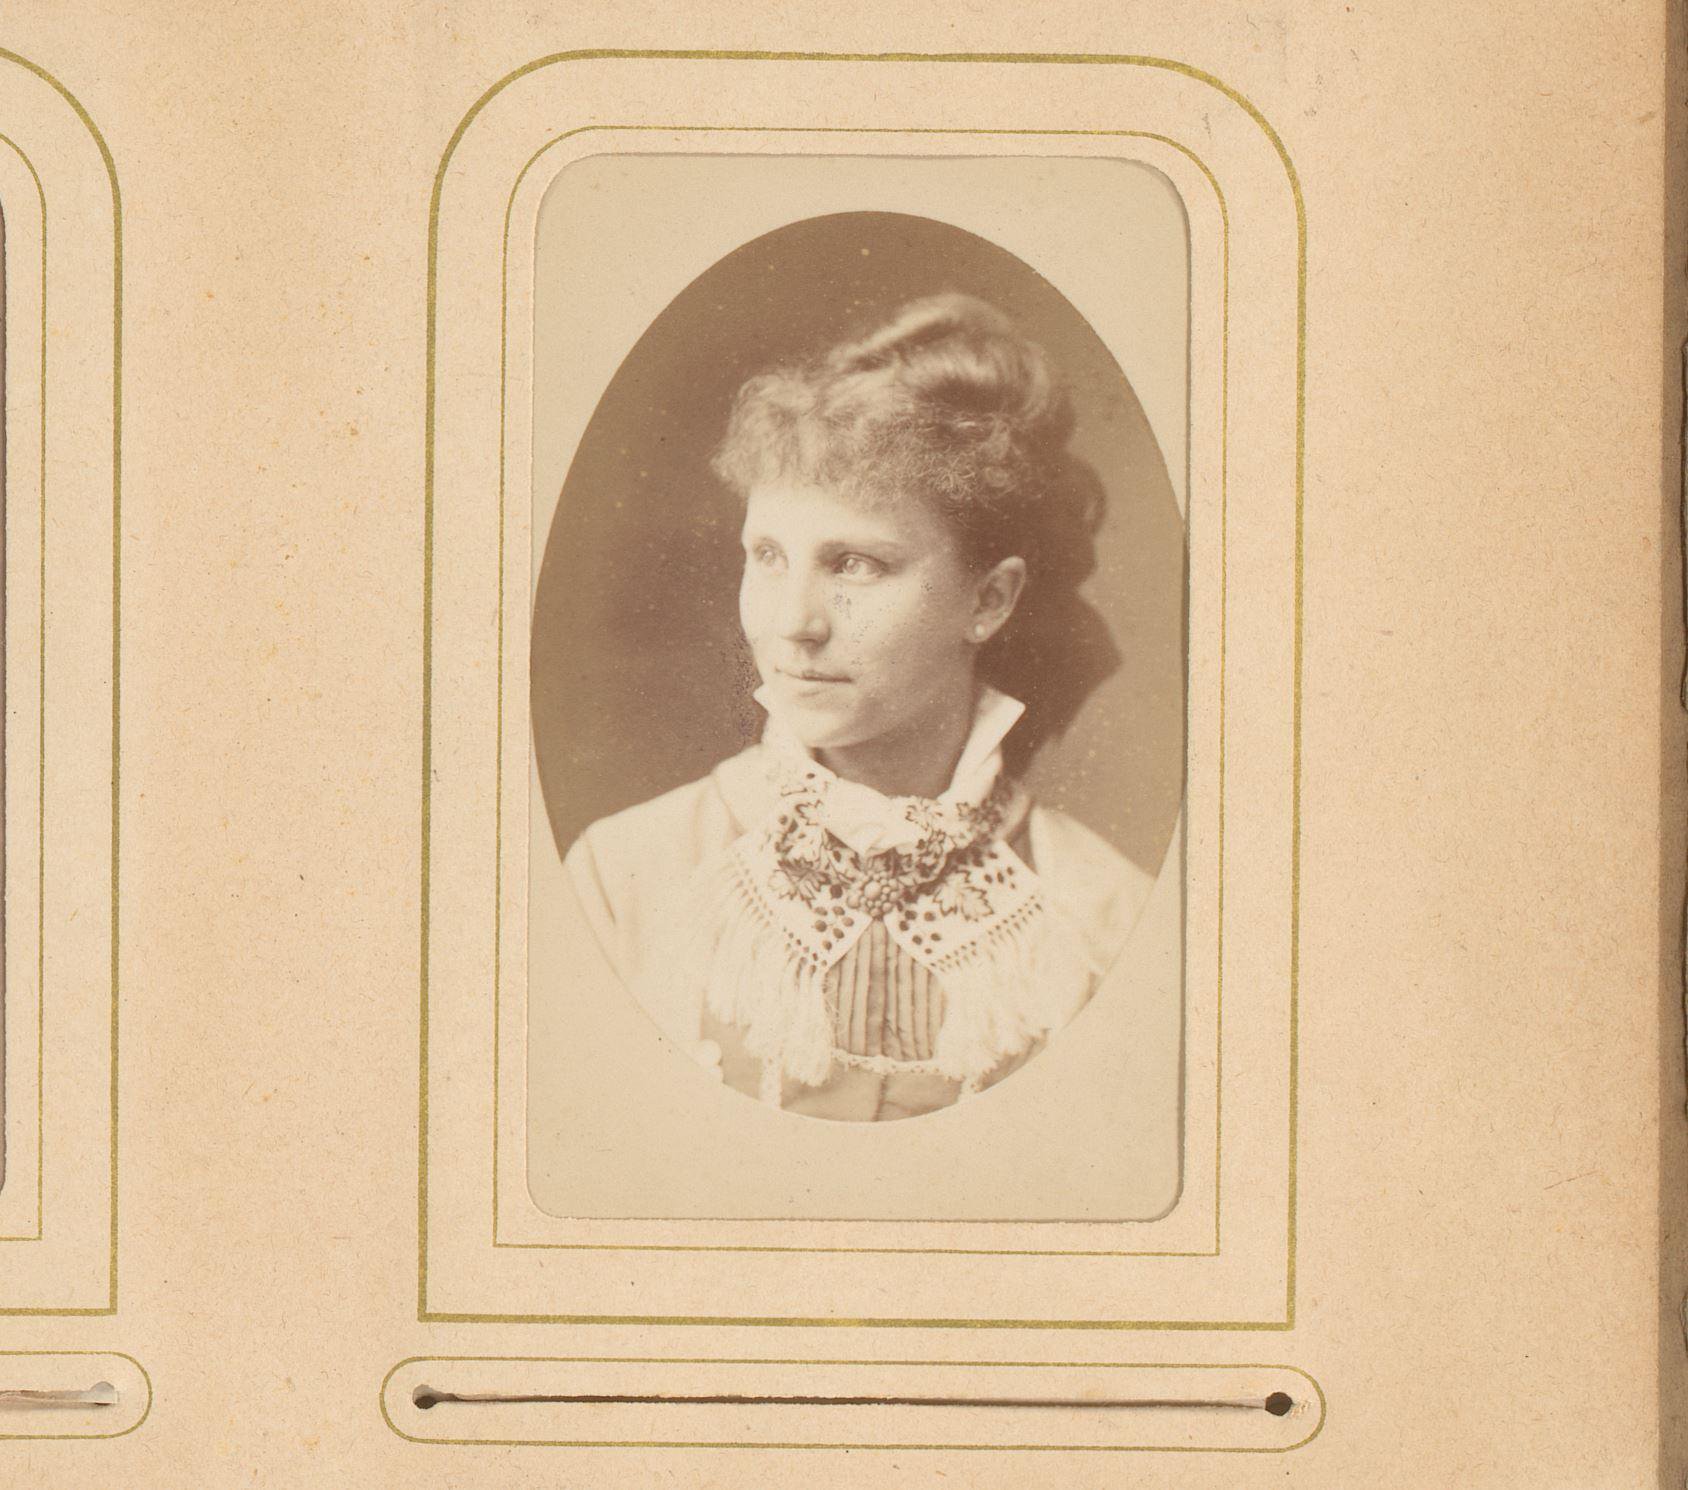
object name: album leaf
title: Portret van een vrouw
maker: johannes baer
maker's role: fotograaf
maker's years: 1840-1912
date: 1873-1891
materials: cardboard, photographic support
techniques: albumen print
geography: rotterdam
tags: historical persons - bb - woman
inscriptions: inscription: ‘Photographie/ J. Baer/ Rotterdam/ Schiedamsche Singel 55.’